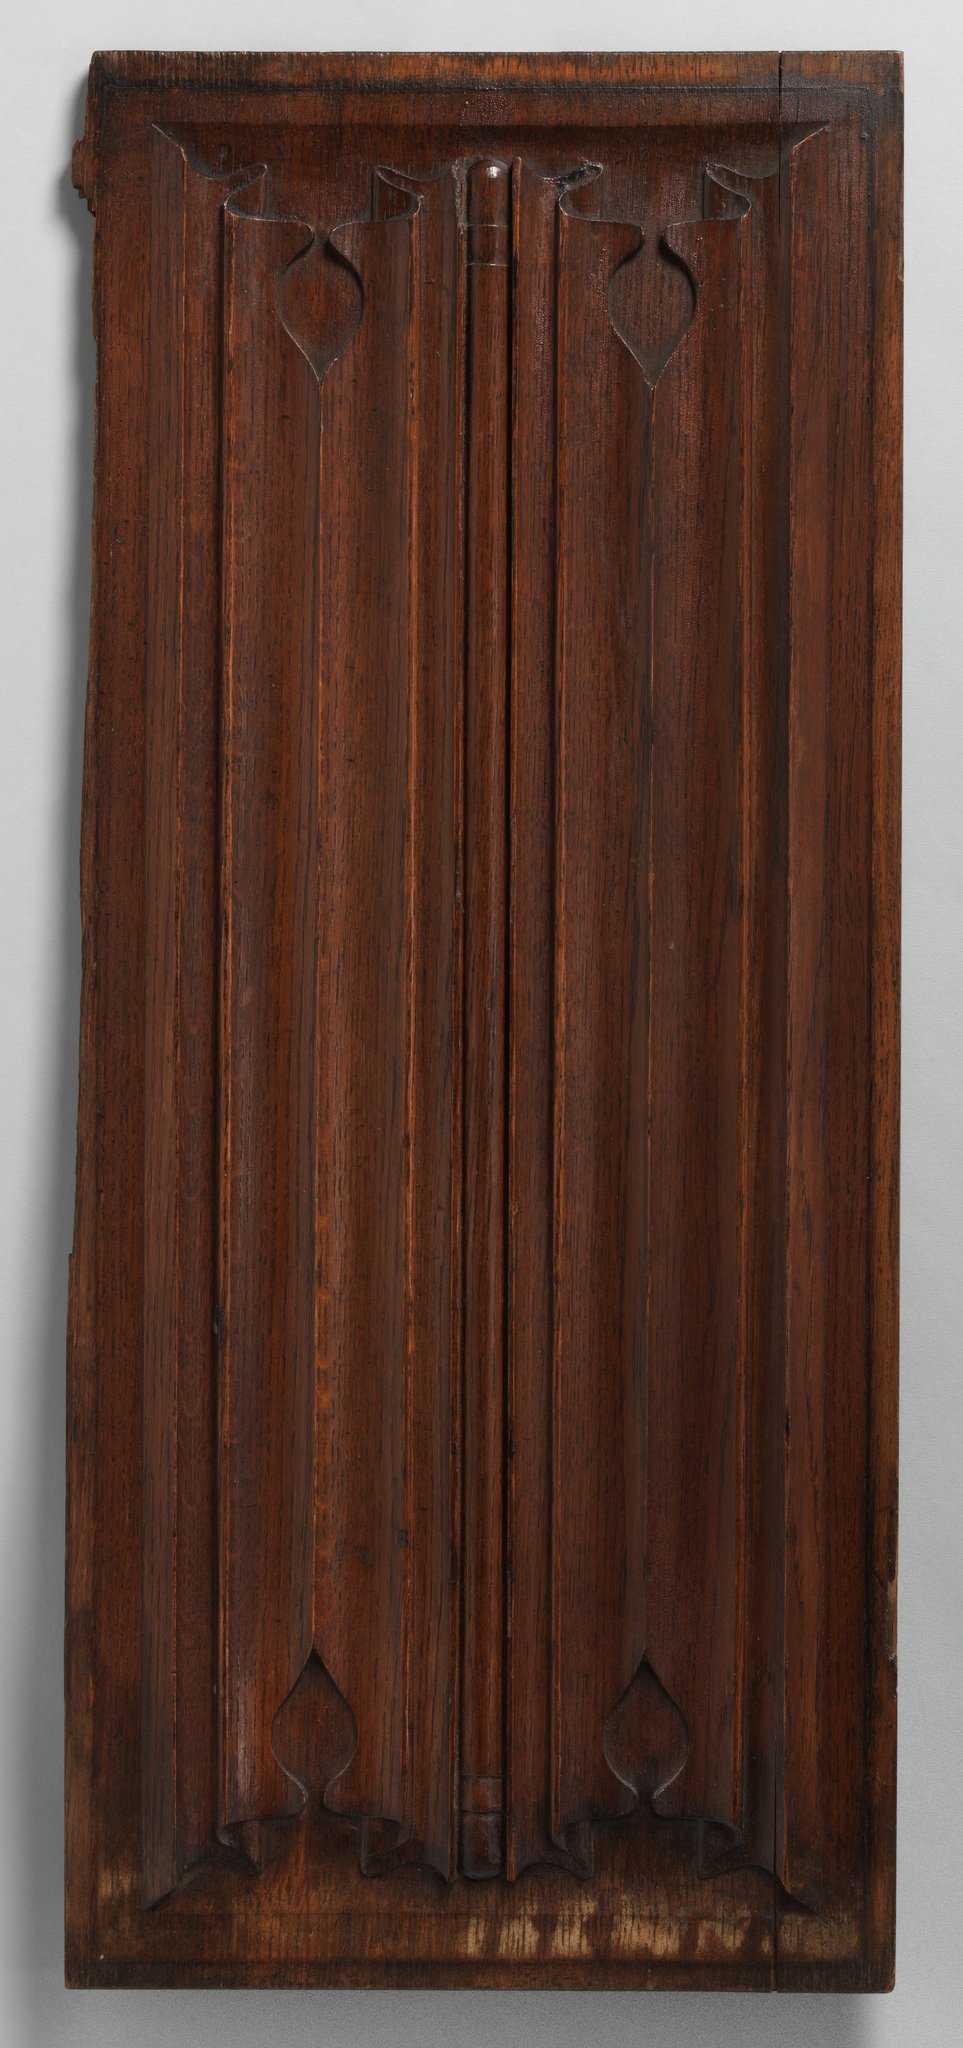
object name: panel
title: Decorative paneling from the Palace of Westminster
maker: augustus welby northmore pugin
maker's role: designer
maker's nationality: british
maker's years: 1812-1852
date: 1845-1859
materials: wood